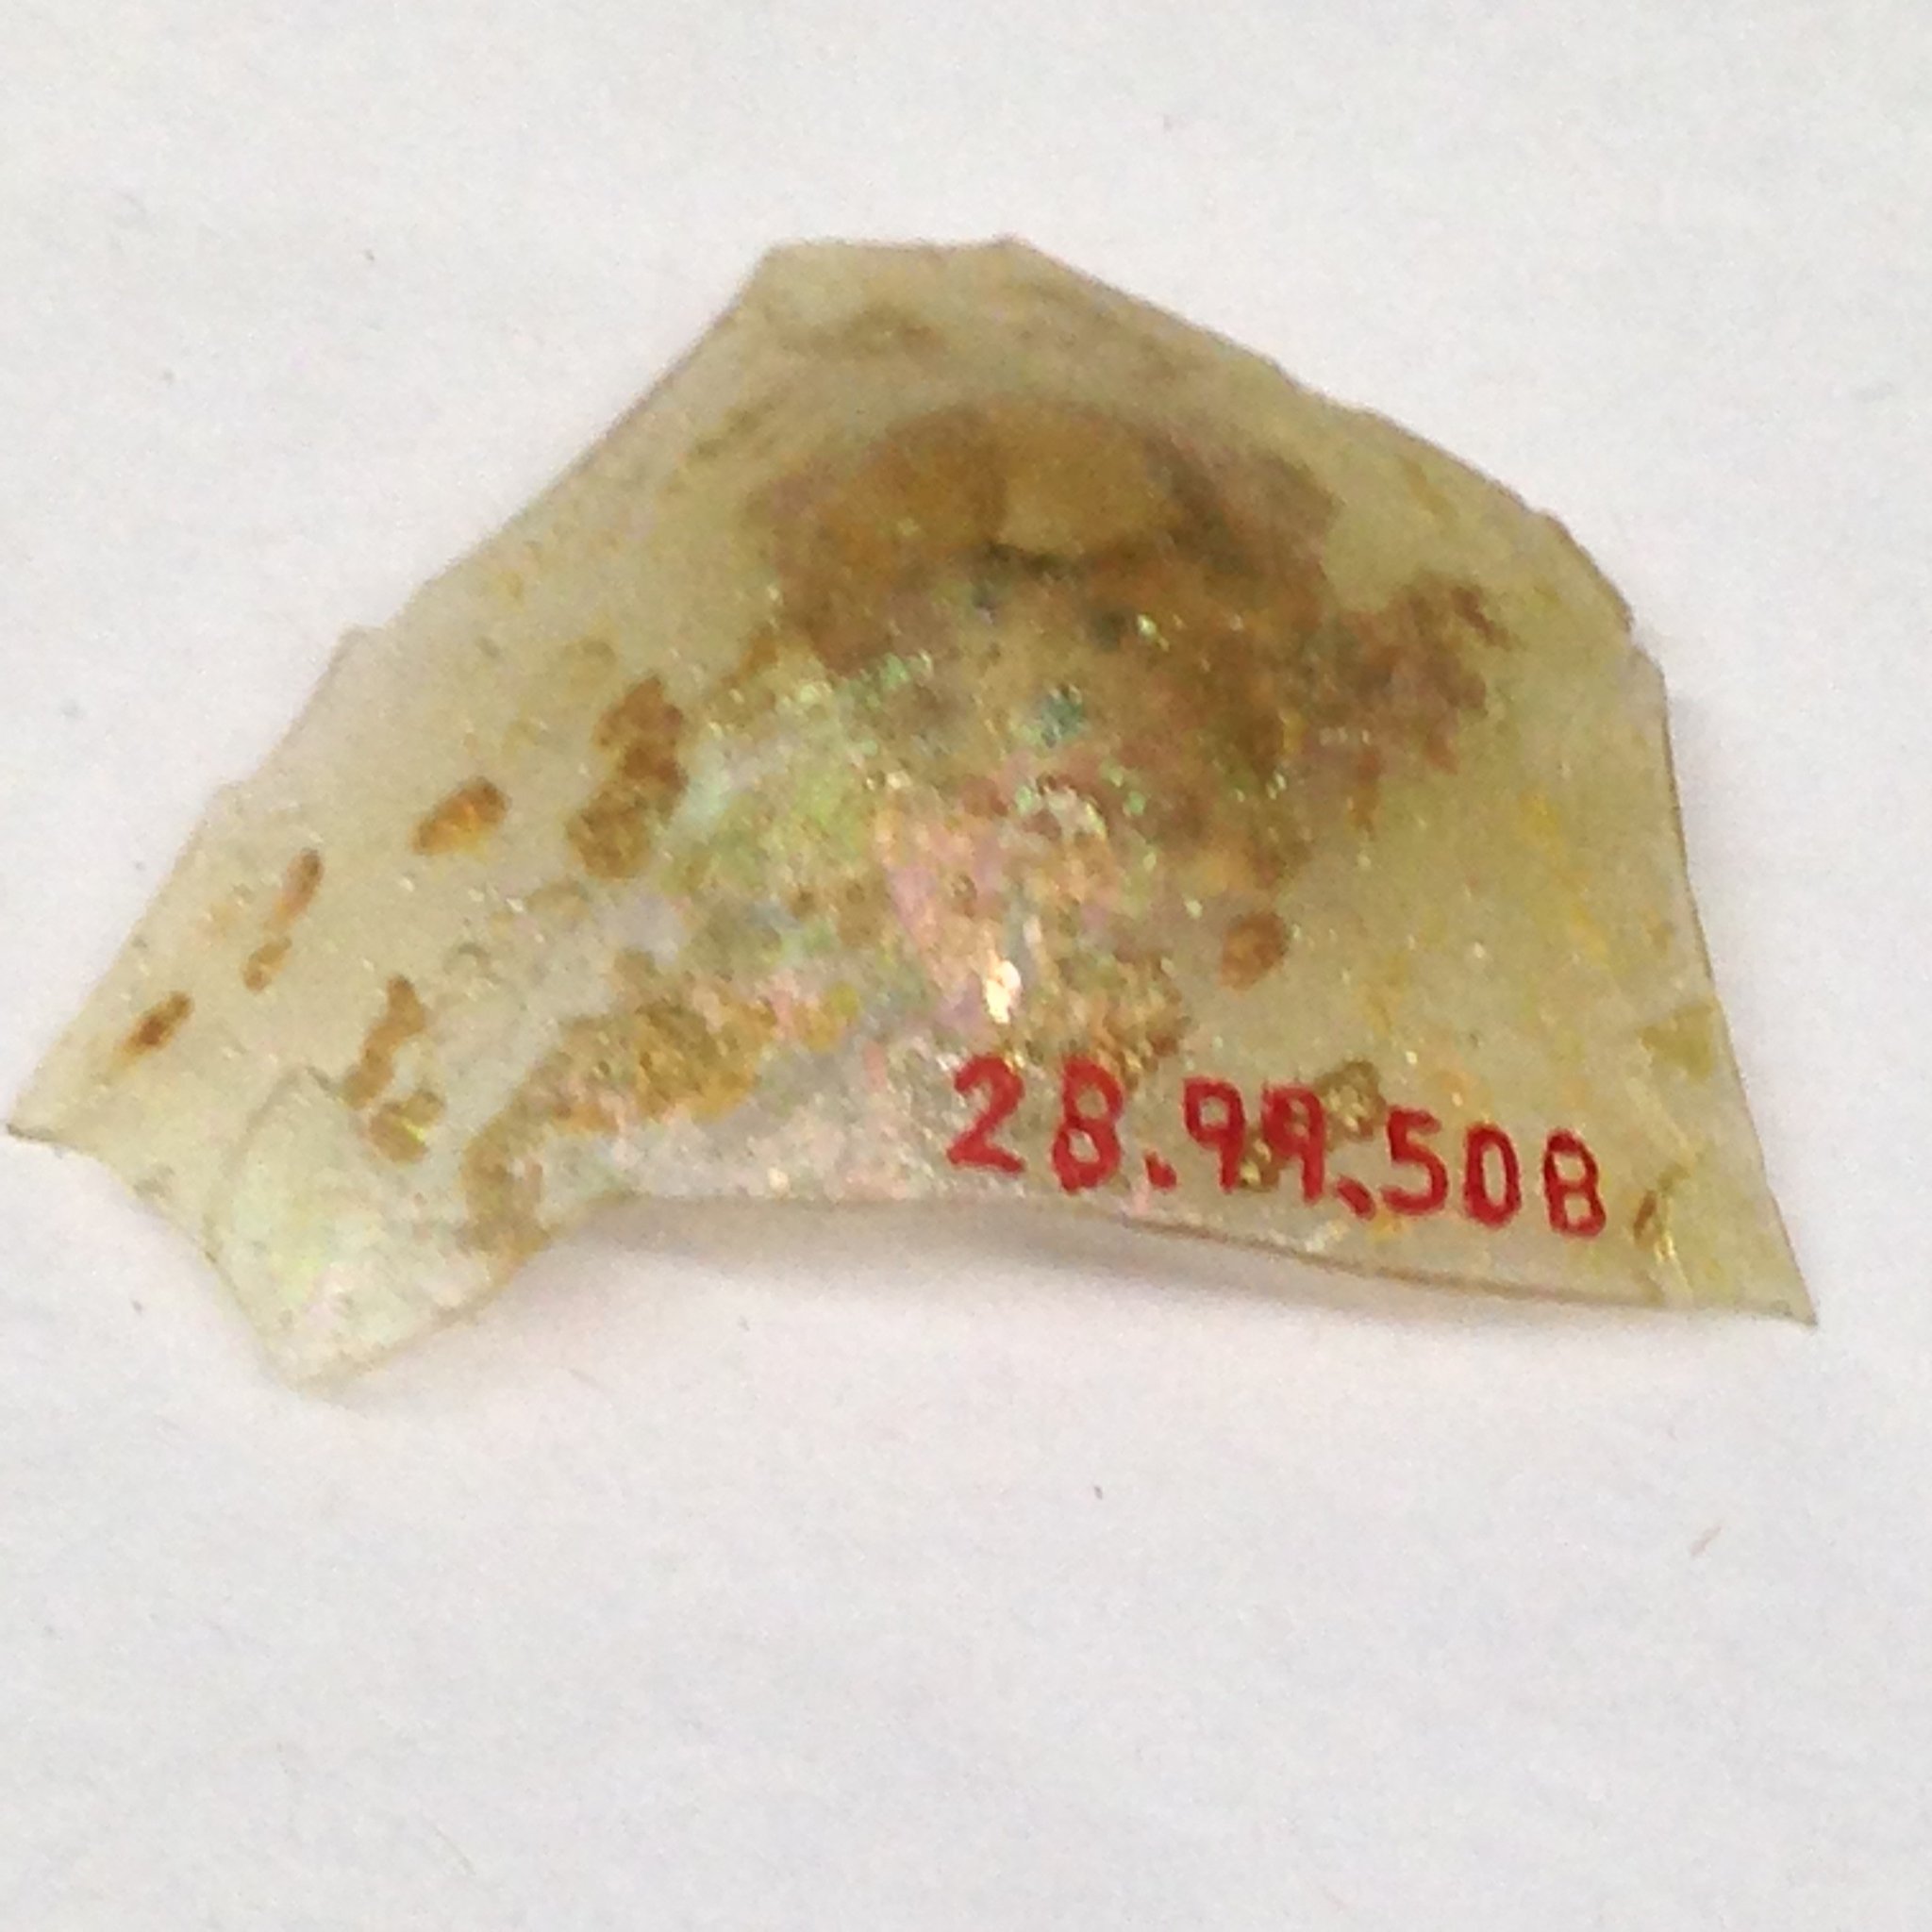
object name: fragment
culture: european or middle eastern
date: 1150-1250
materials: ceramic, glass